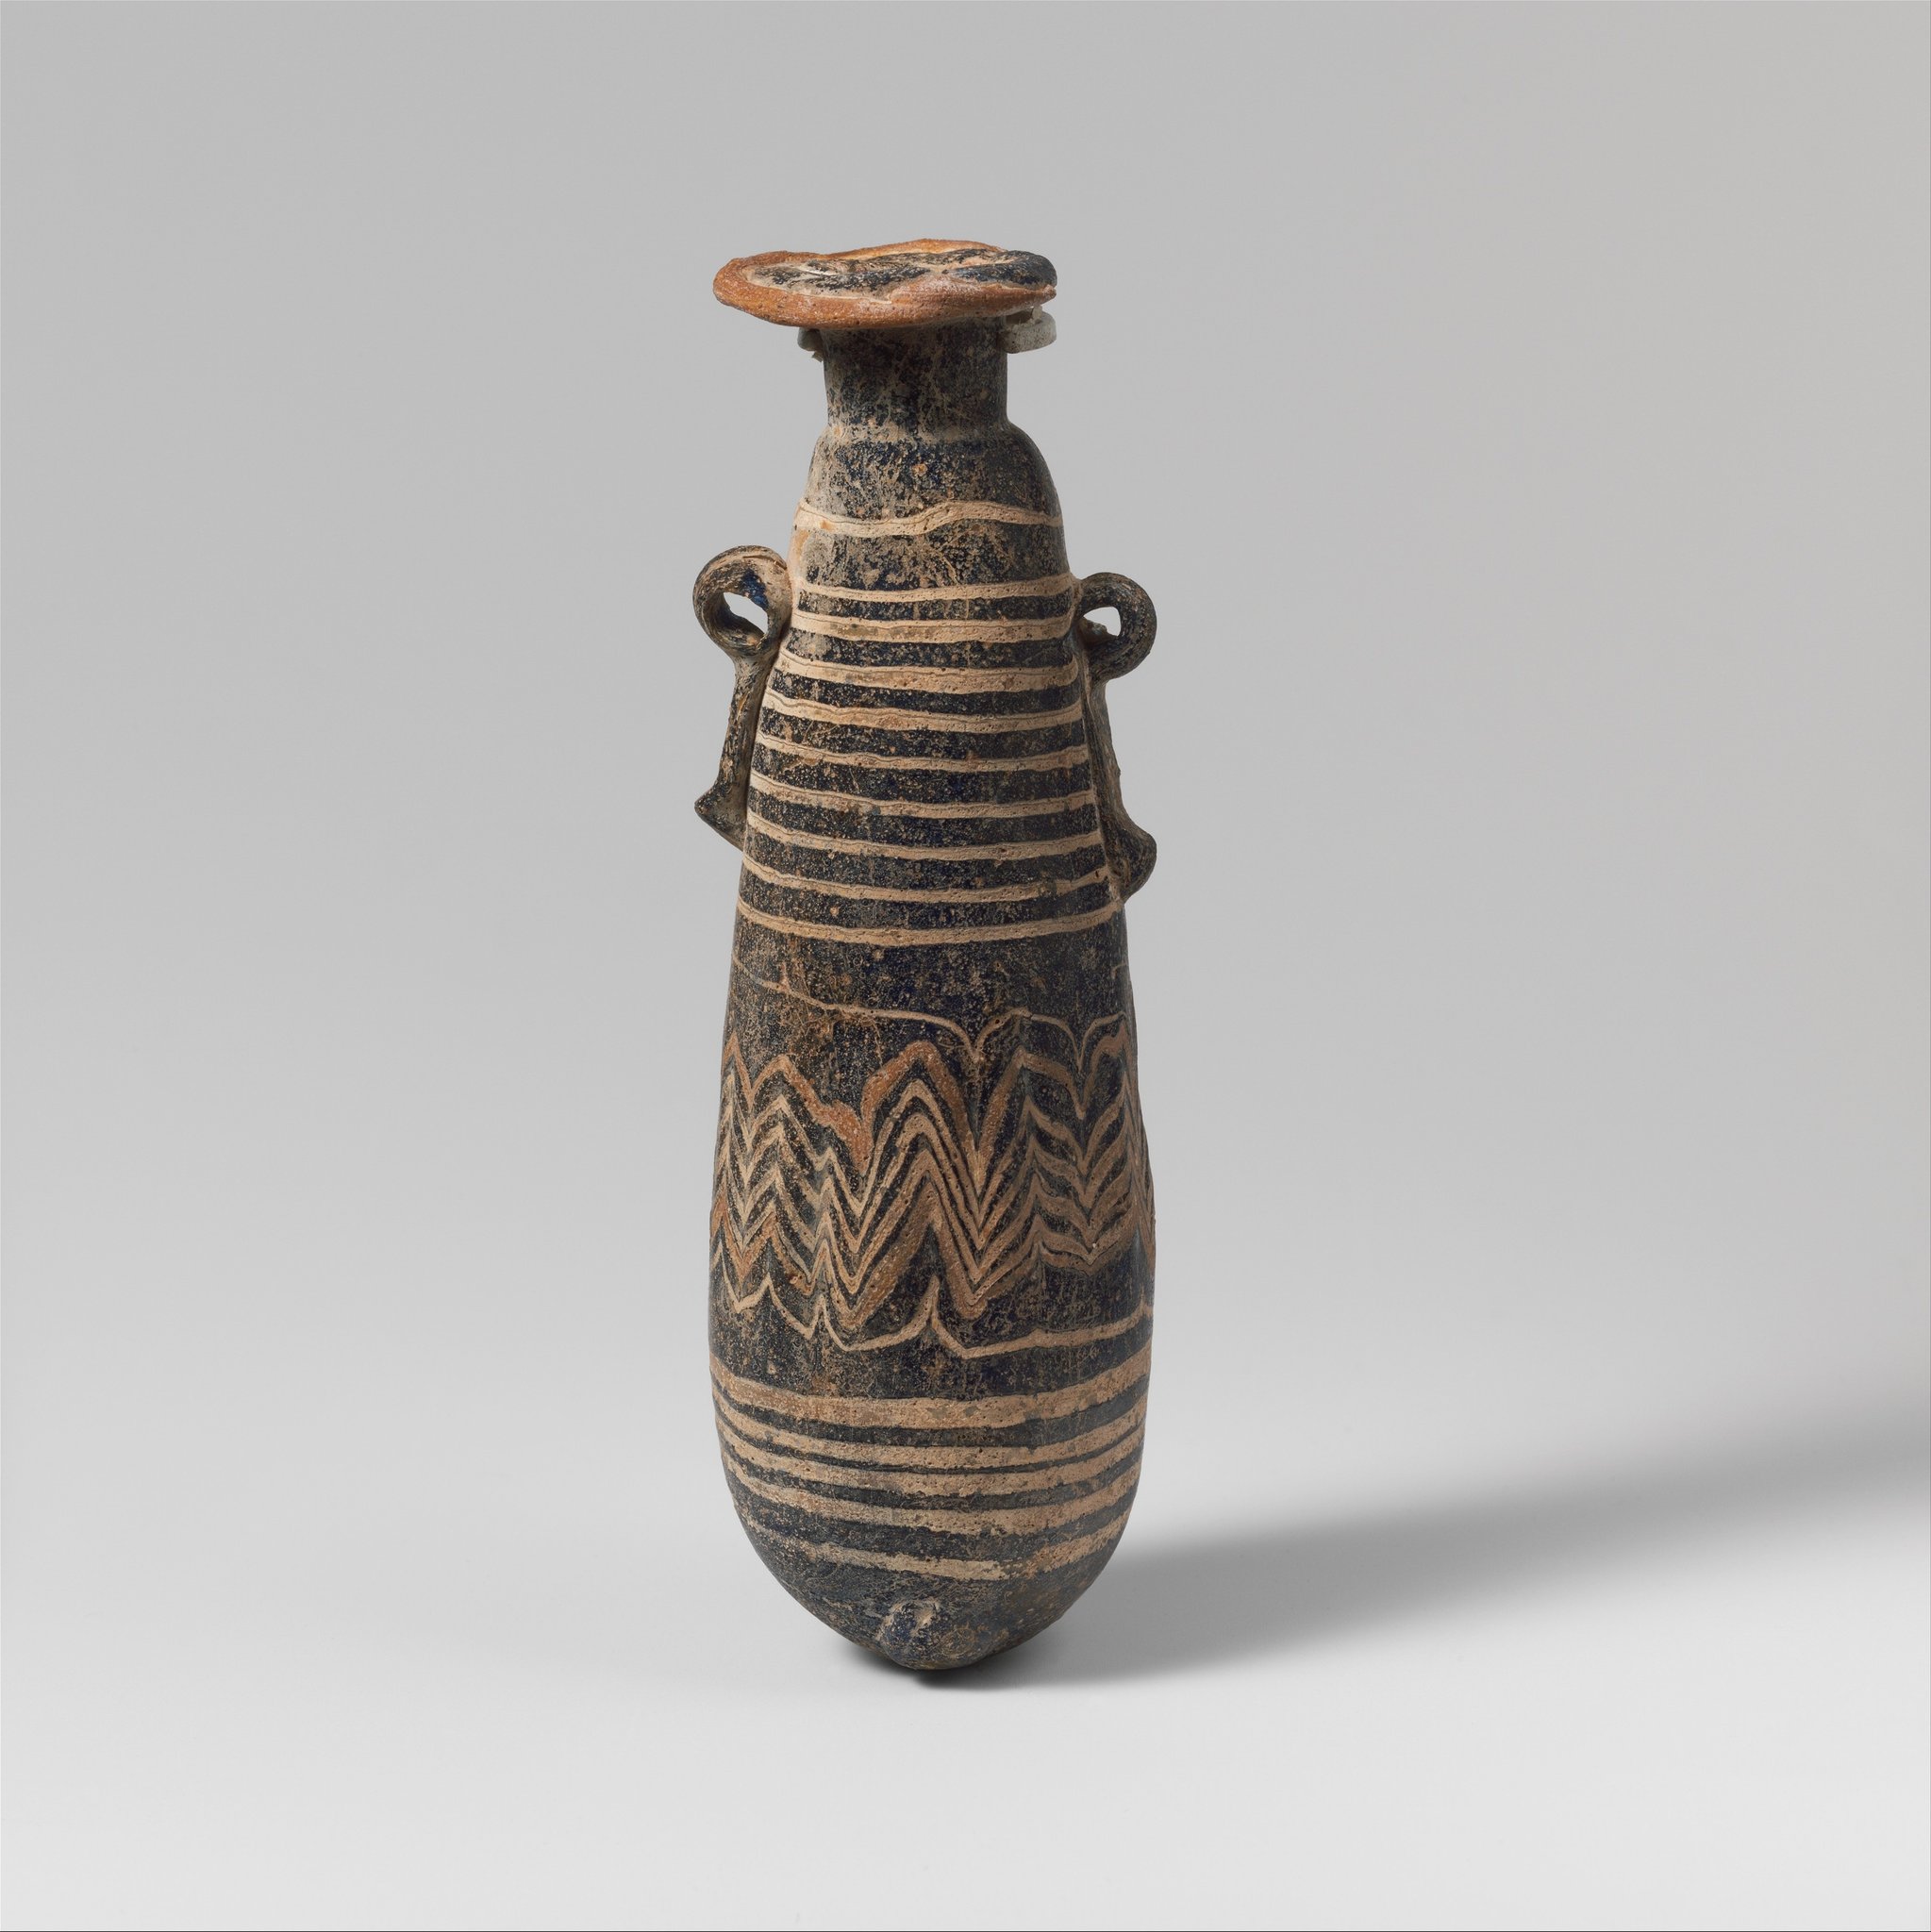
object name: alabastron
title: Glass alabastron (perfume bottle)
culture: greek, eastern mediterranean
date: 534-401 BCE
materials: glass